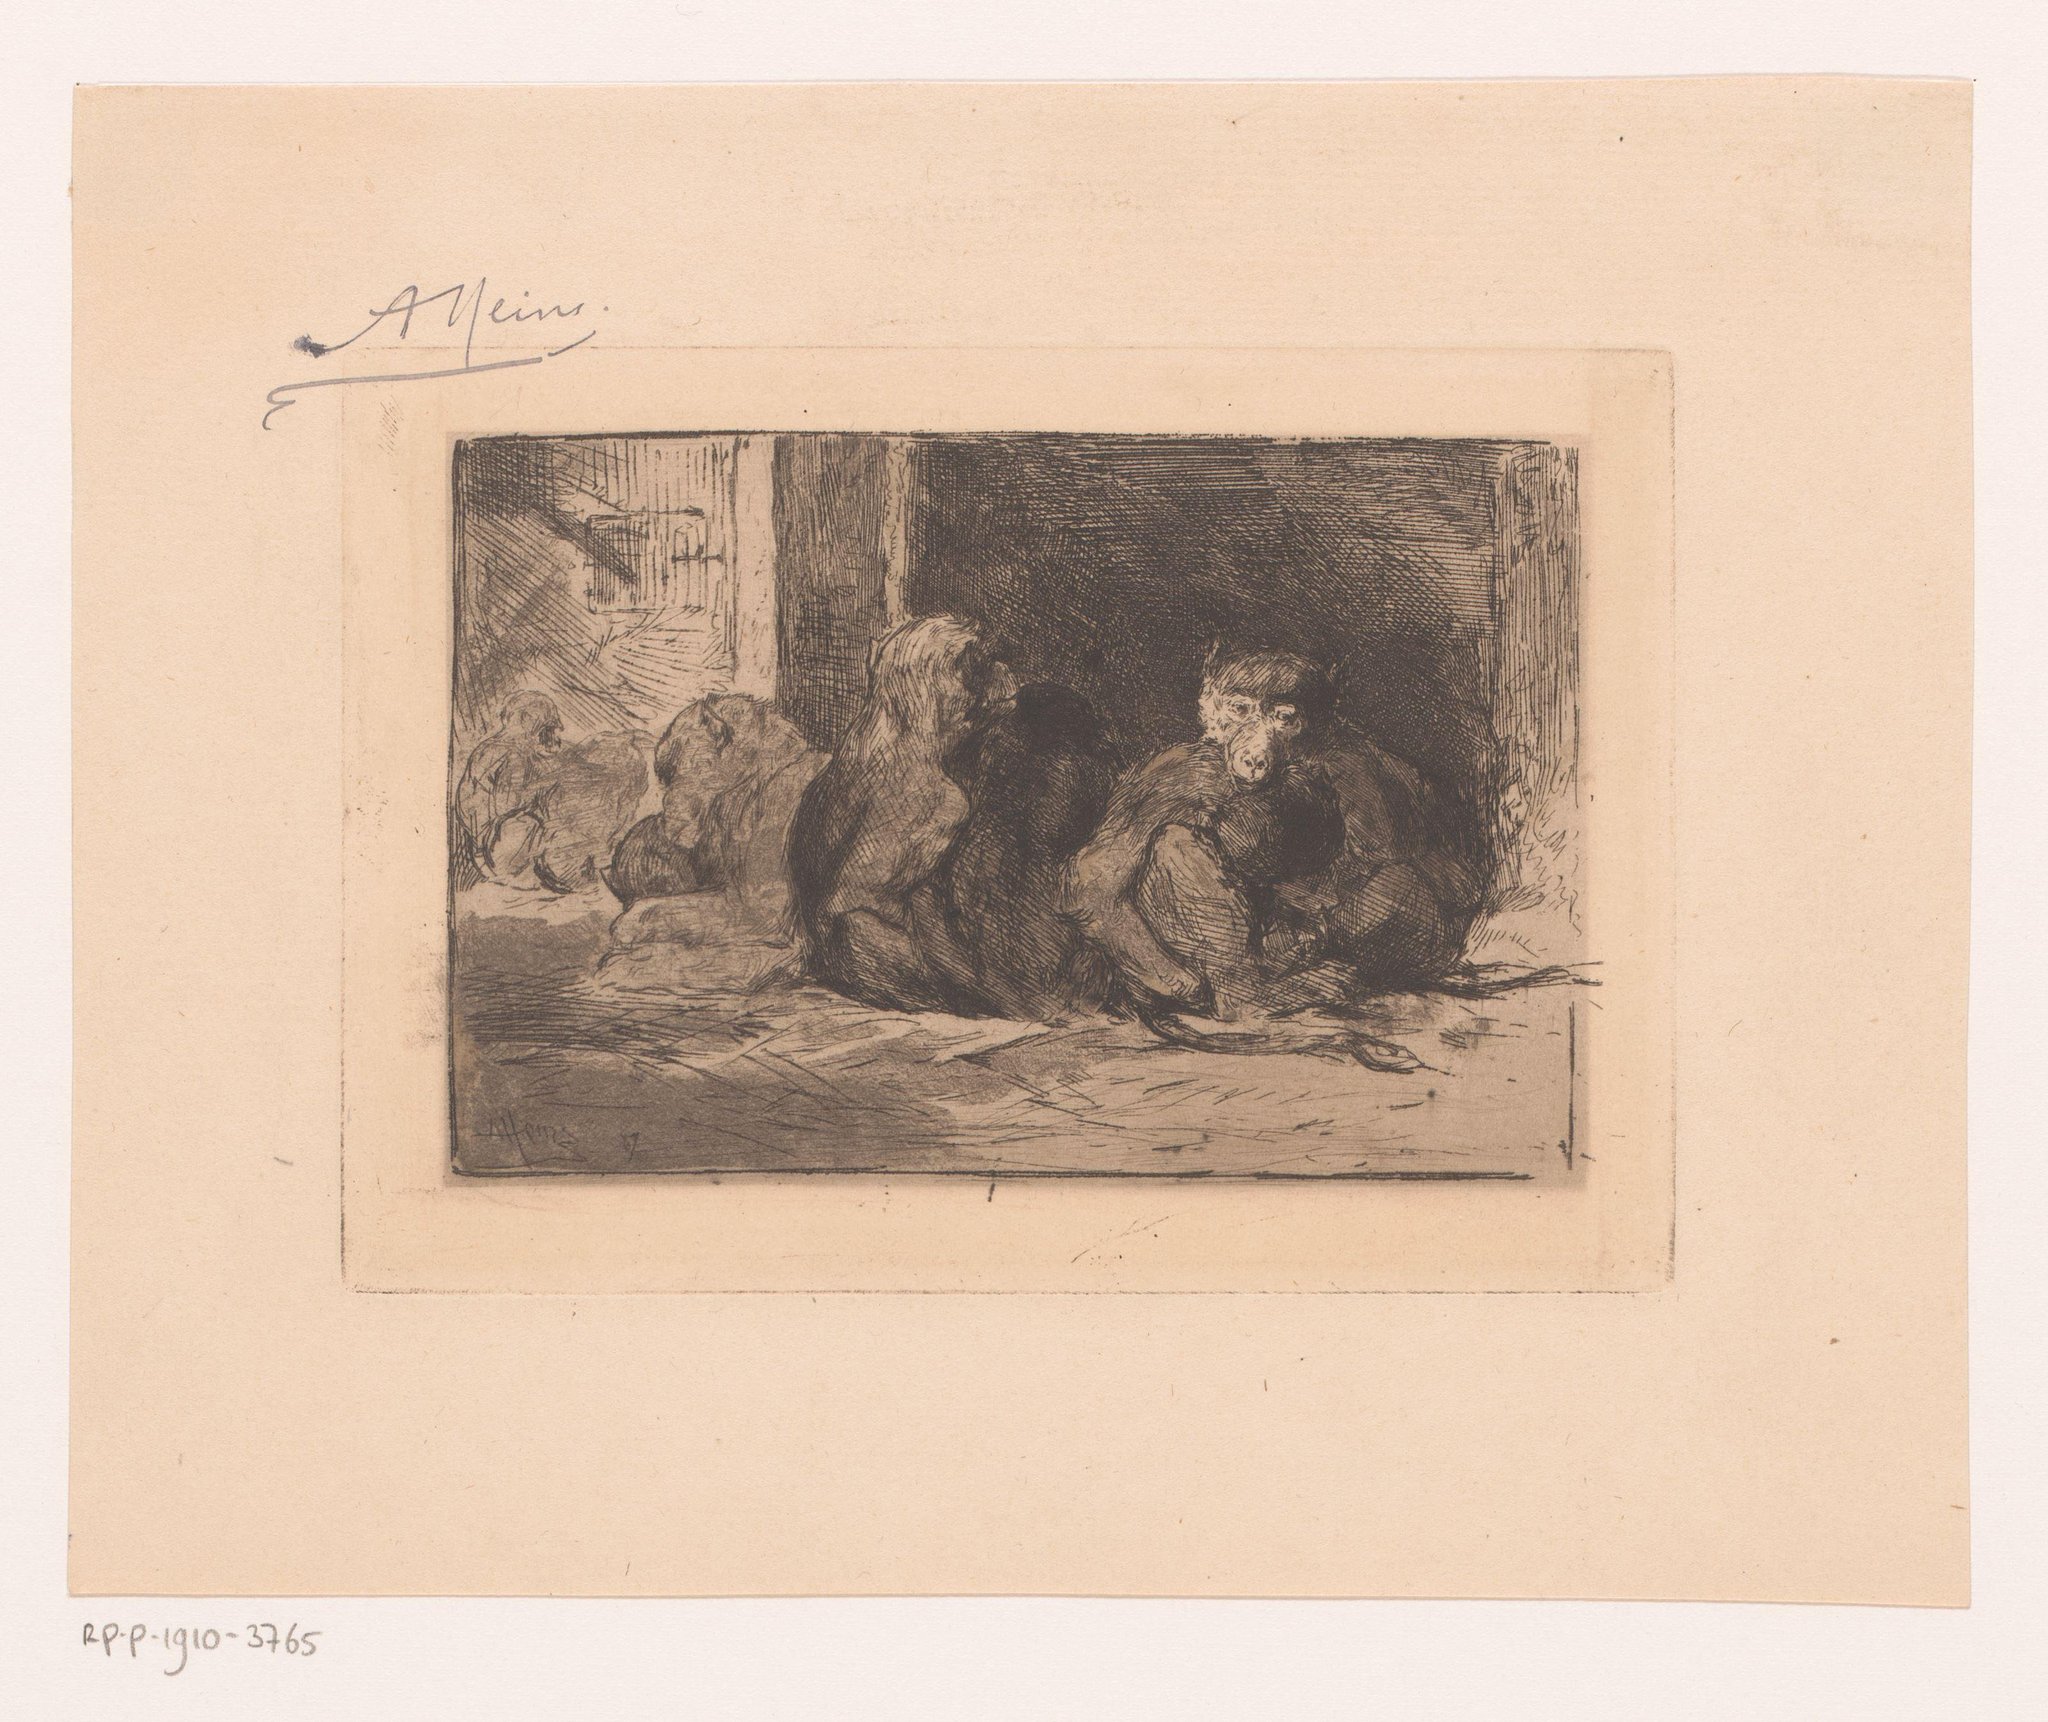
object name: print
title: Groep apen in een verblijf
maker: armand heins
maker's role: print maker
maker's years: 1856-1938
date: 1887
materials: paper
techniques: etching, intaglio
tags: monkeys, apes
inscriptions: collector's mark: Lugt 2228